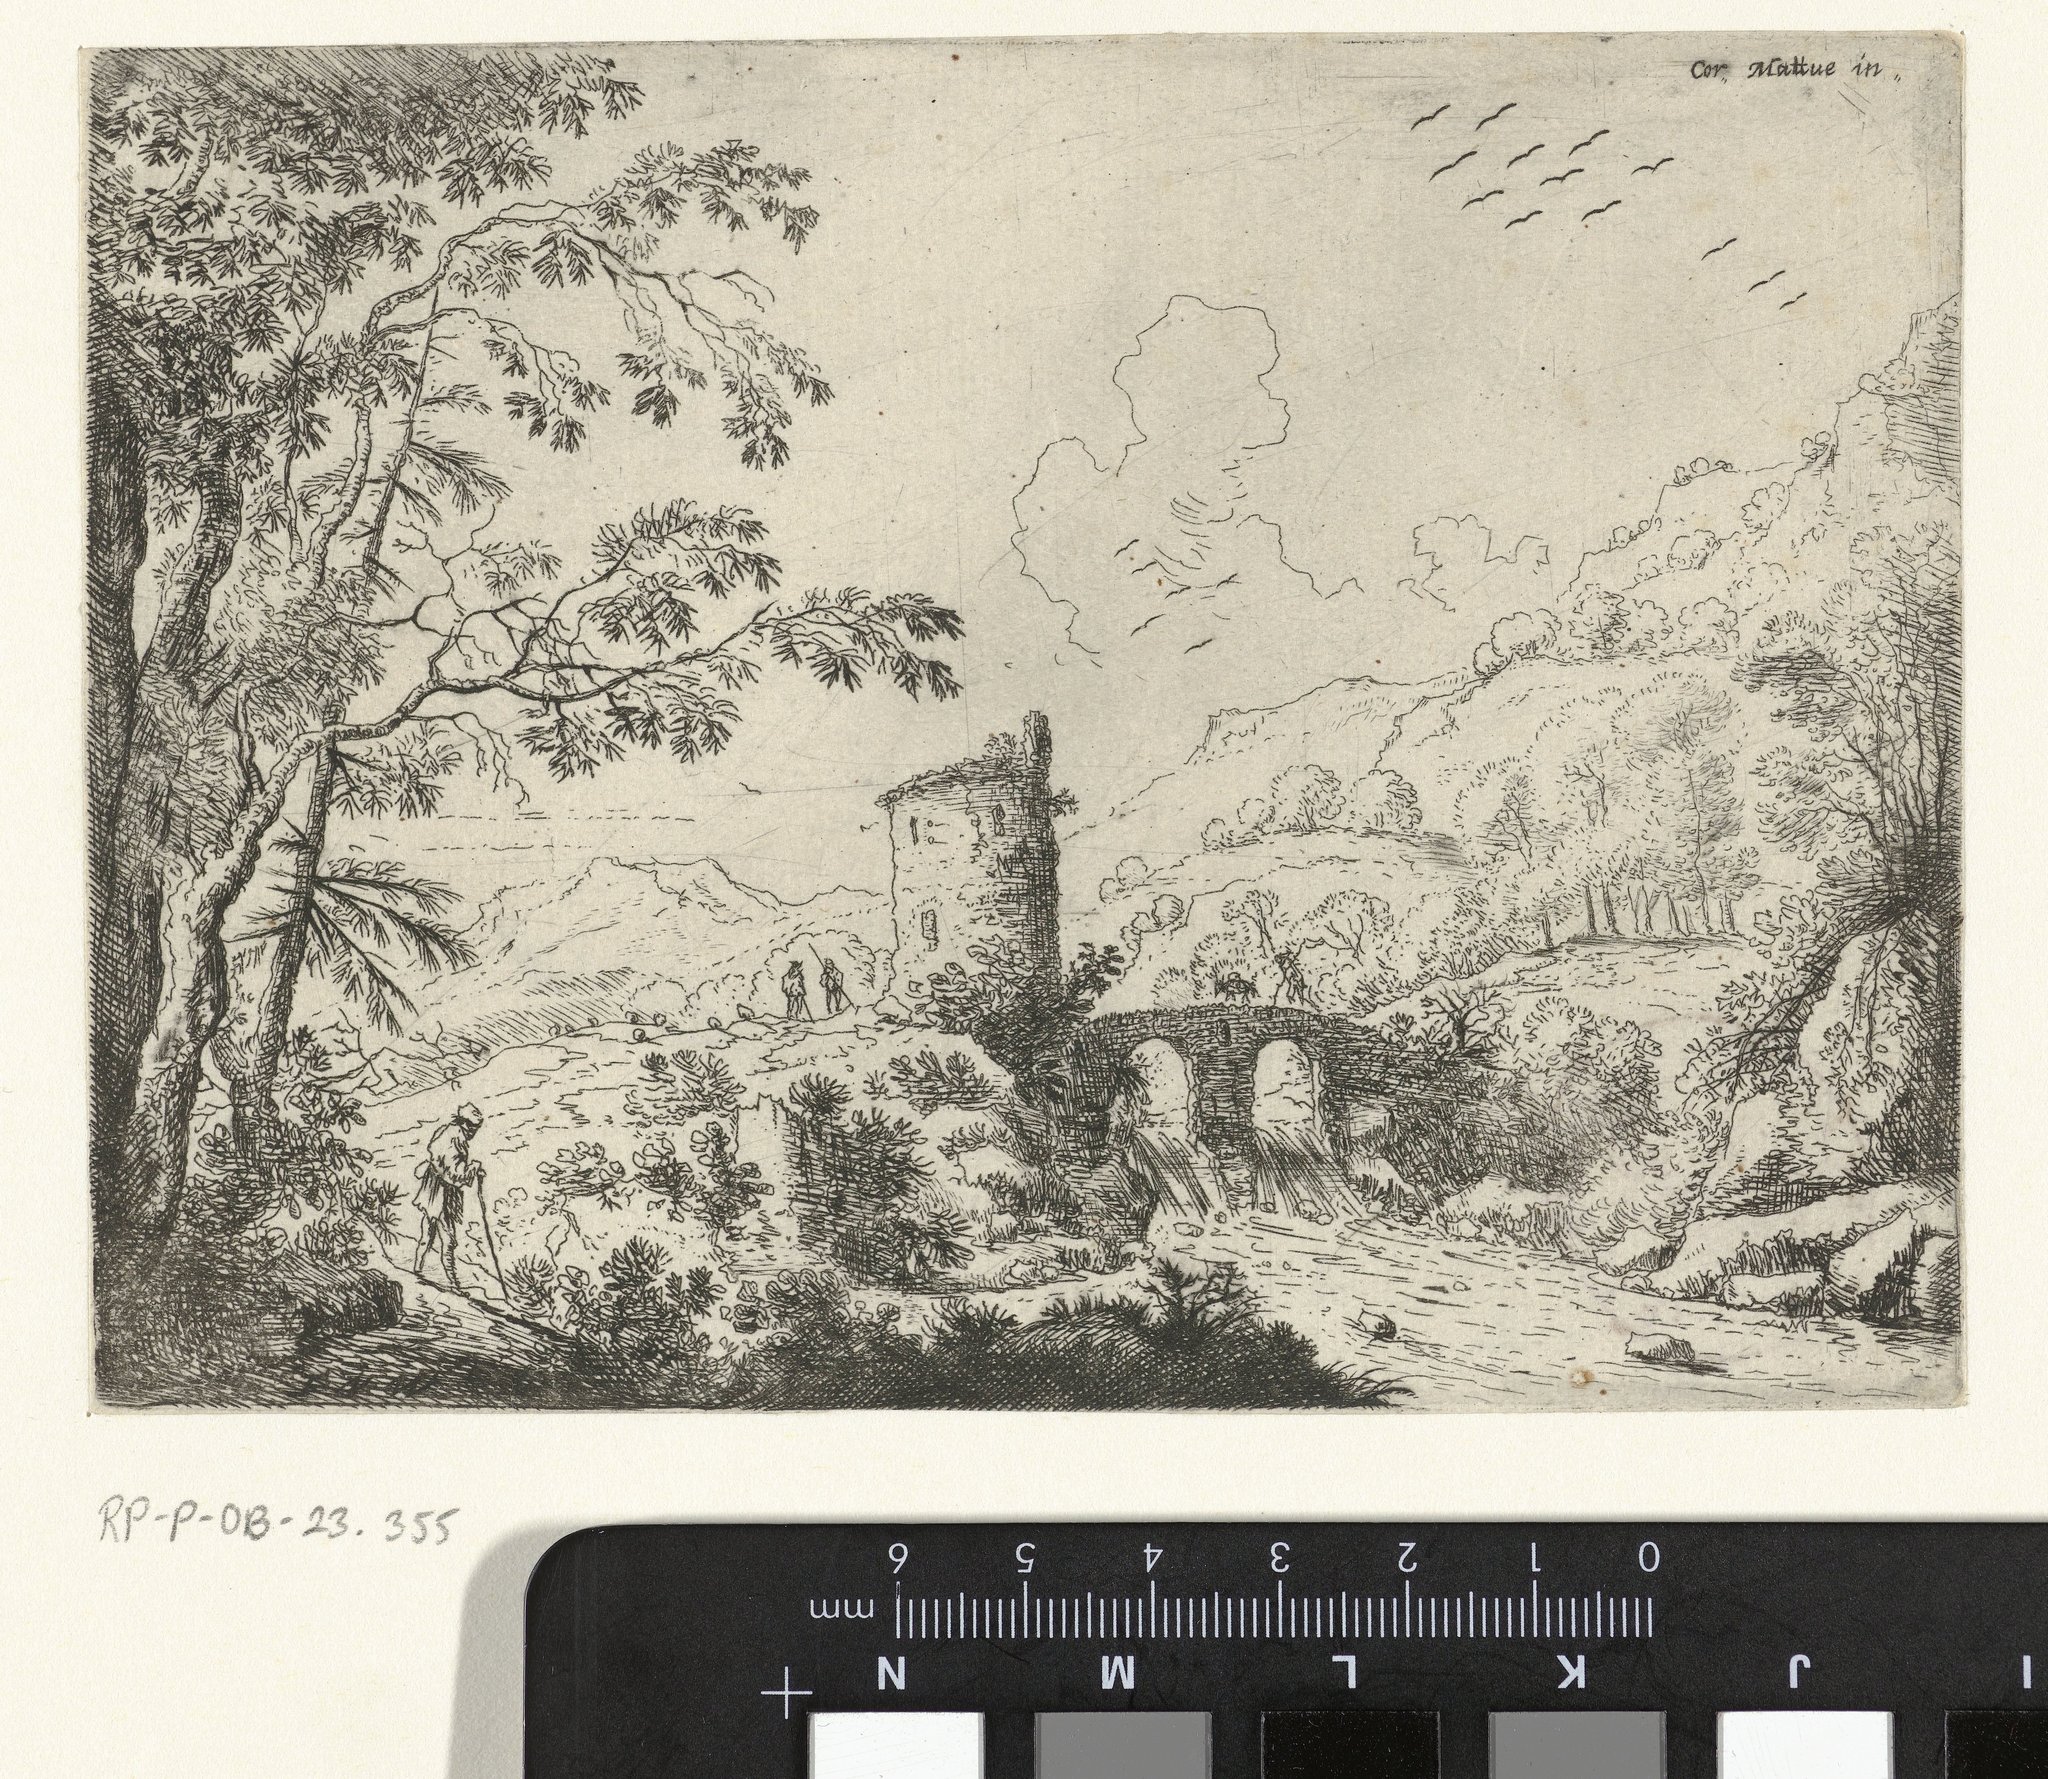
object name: print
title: Landschap met een brug en een toren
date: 1637-1656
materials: paper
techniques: engraving, etching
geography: antwerp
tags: landscape with bridge, viaduct or aqueduct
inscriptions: collector's mark: Lugt 240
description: Landschap met een brug over een rivier en een toren. Op de voorgrond een man met een staf.